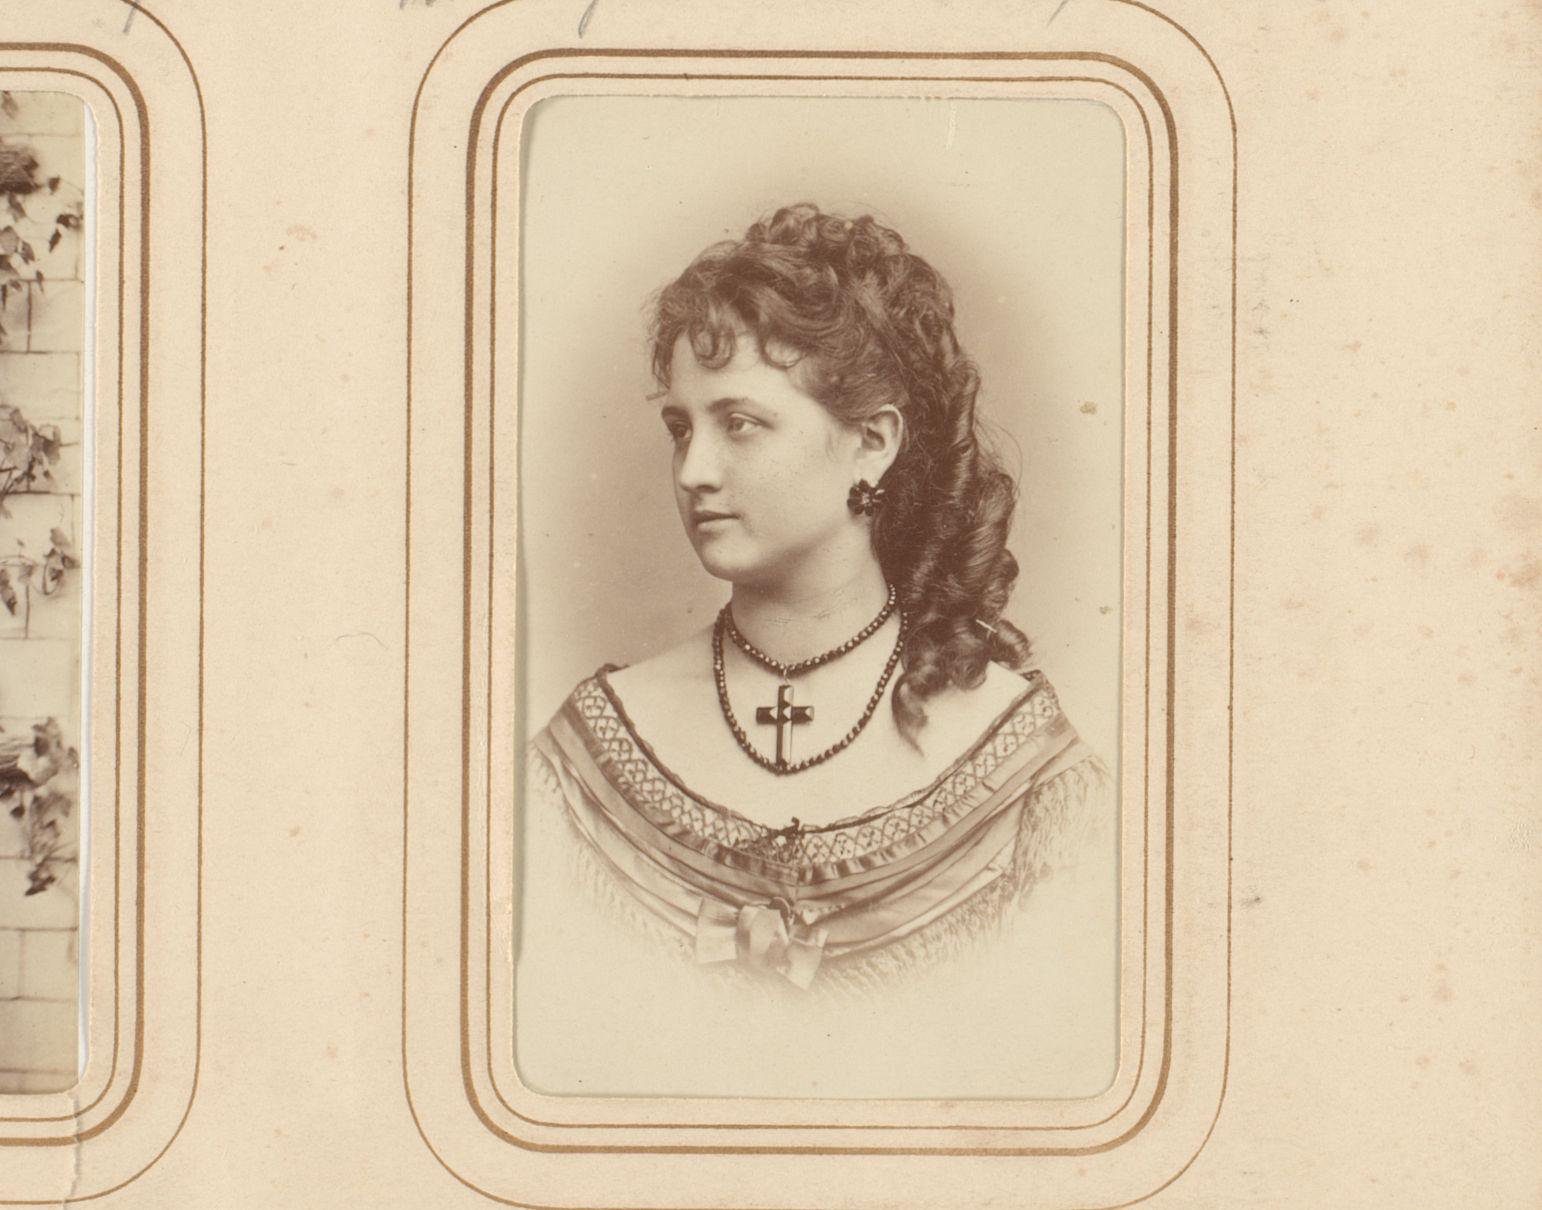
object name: photograph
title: Portret van een vrouw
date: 1870-1890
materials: cardboard, photographic support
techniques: albumen print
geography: netherlands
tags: adult woman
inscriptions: inscription: ‘Wegner & Mottu. Phot. Amsterdam & Utrecht.’, inscription: ‘Photogr. Atelier / Wegner & Mottu / Kalverstraat / over den Heyligenweg, D. 26. / Amsterdam / Leydsche Straatweg / Buiten Cathrynen / Utrecht’